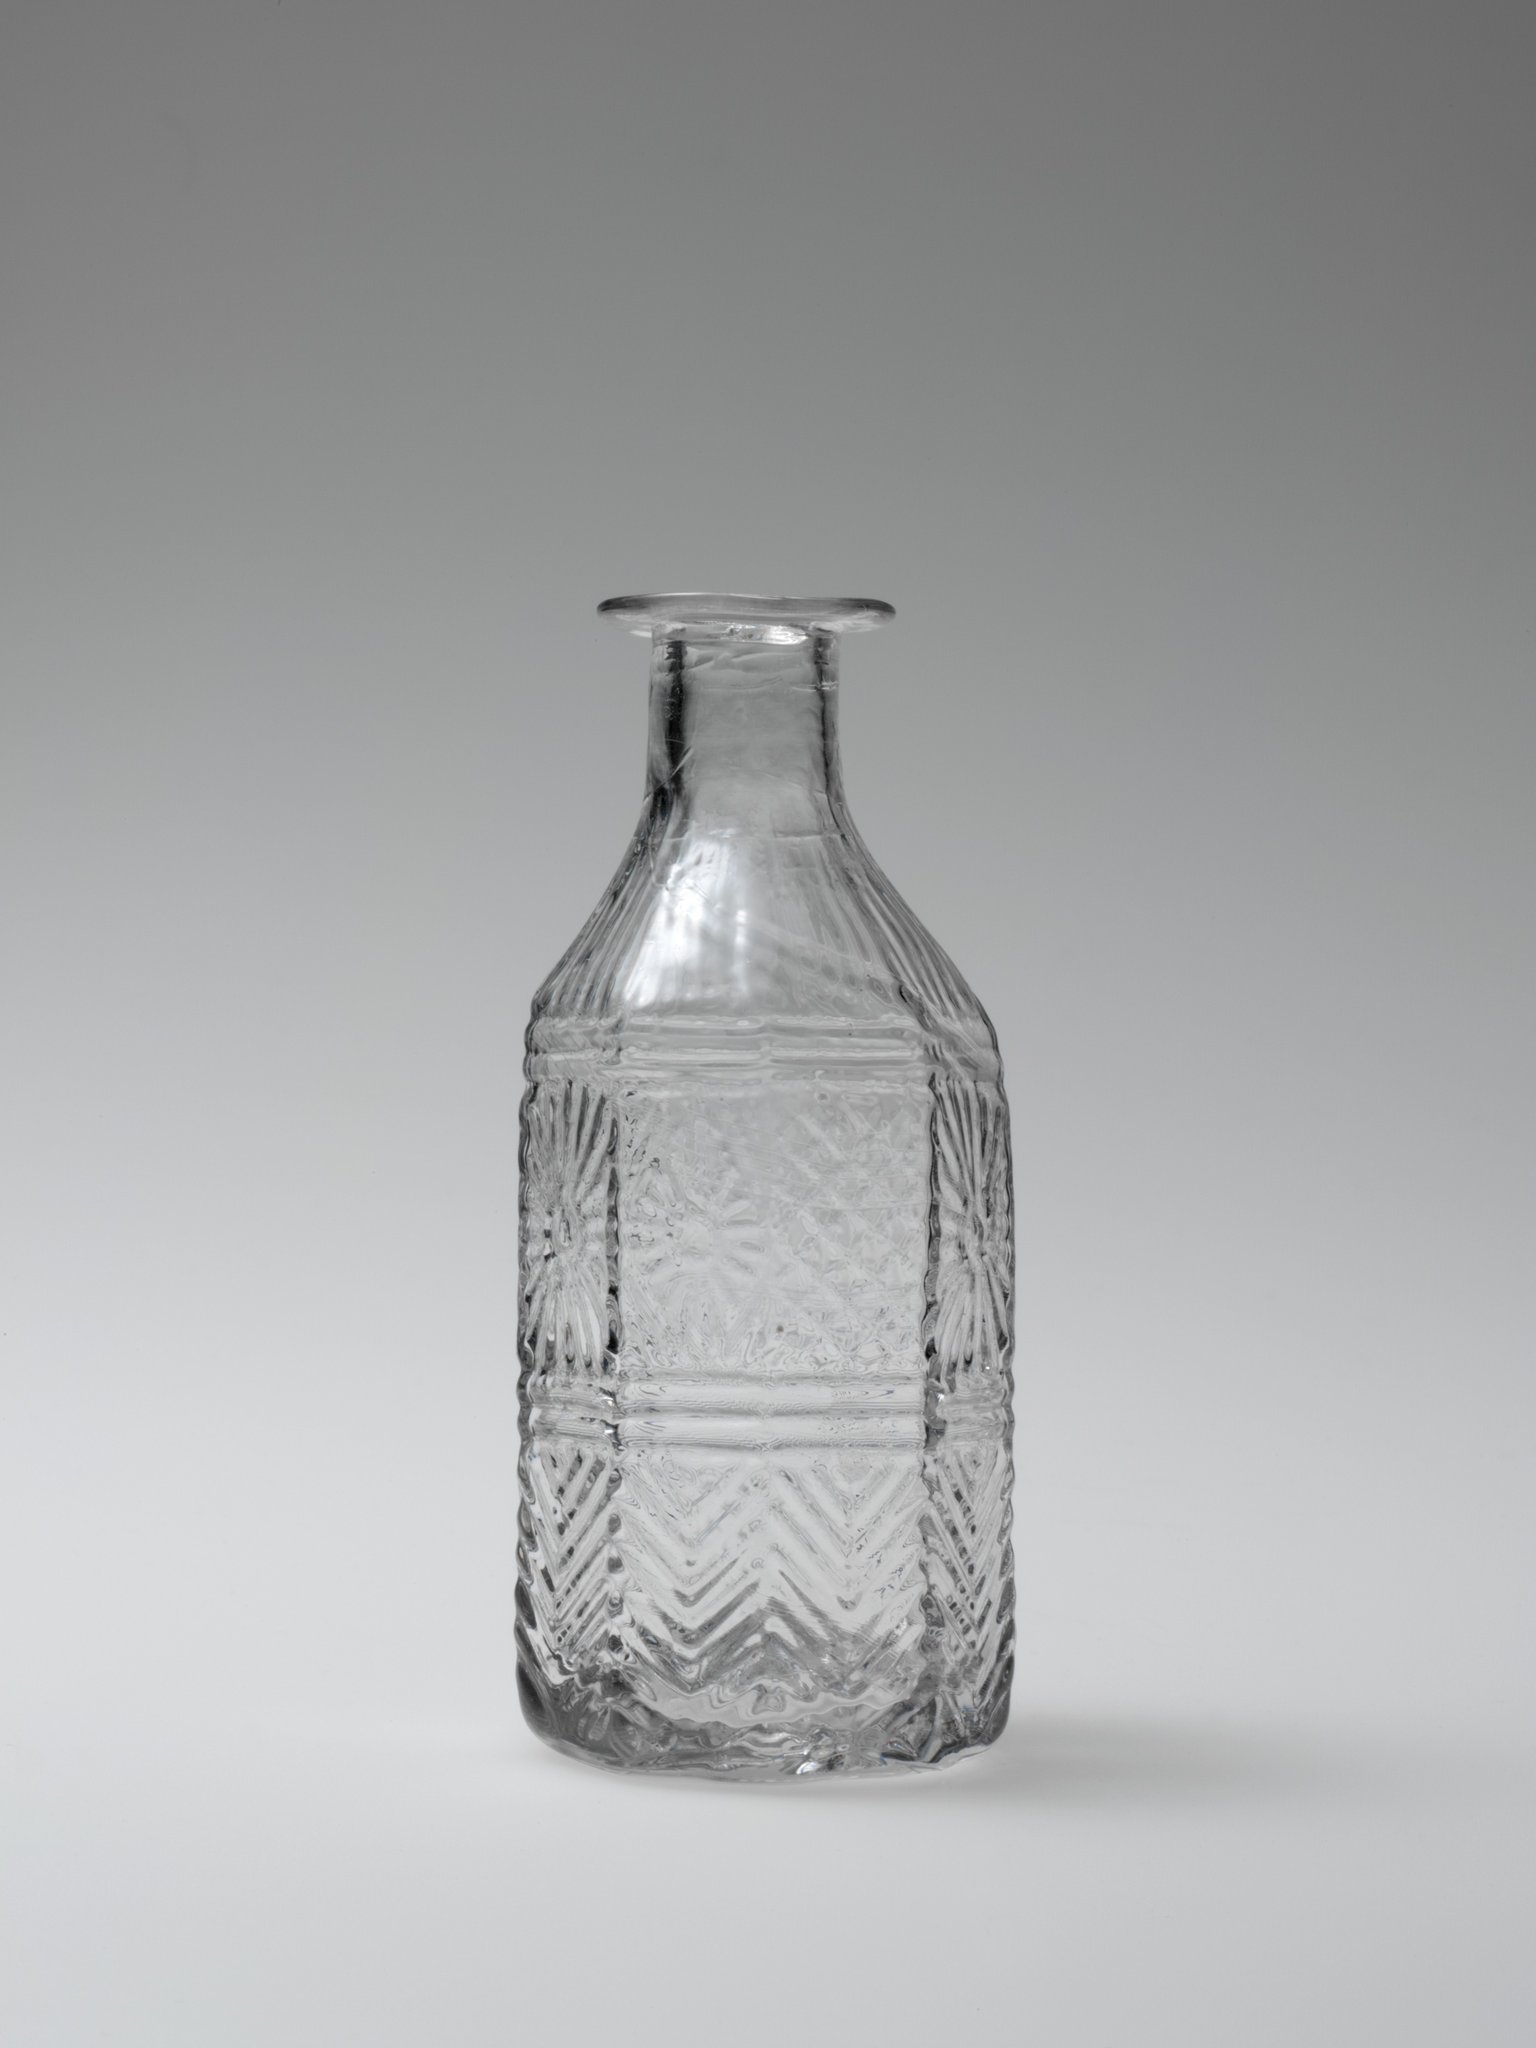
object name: bottle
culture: american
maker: boston & sandwich glass company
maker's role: maker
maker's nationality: american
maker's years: 1825-1888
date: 1825-1840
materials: glass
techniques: glassblowing, molding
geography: united states